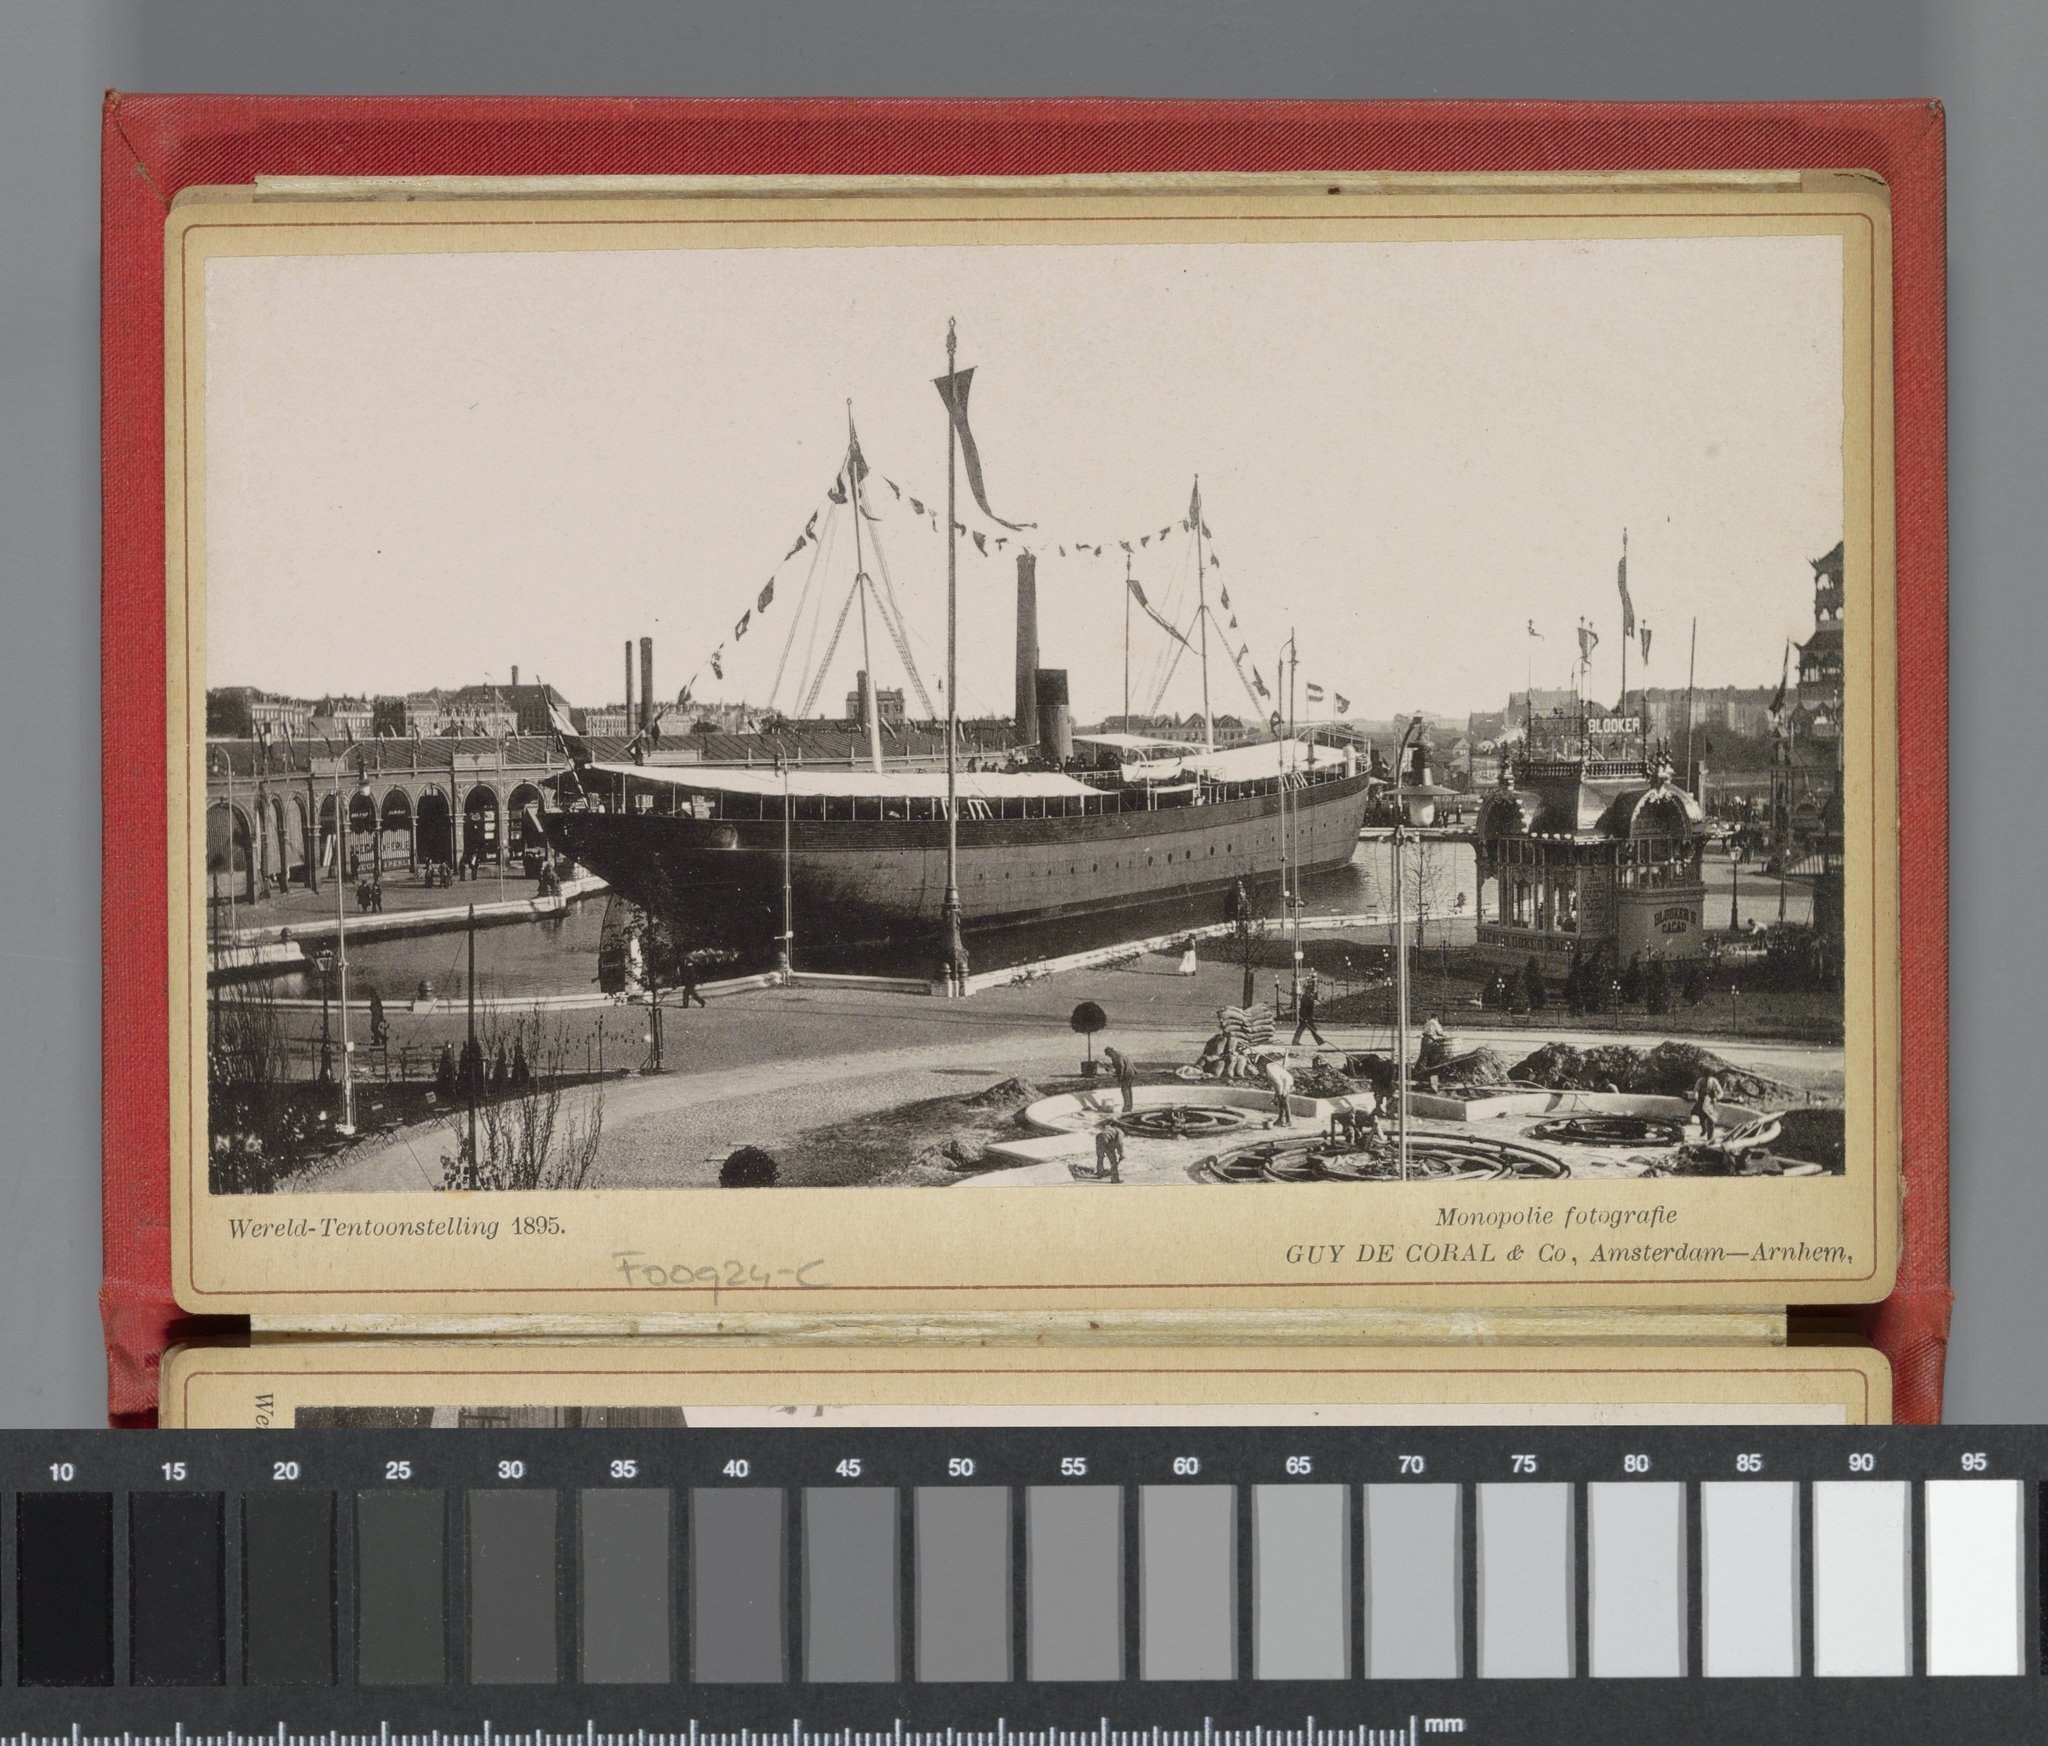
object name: cabinet photograph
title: Wereld-Tentoonstelling 1895.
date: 1895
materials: cardboard, paper, ink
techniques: photograph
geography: amsterdam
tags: prospect of city, town panorama, silhouette of city, temporary exhibition, 'salon', ship-model, amsterdam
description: Onderdeel van Fotoalbum met opnames van de Wereldtentoonstelling voor het Hotel- en Reiswezen op het Museumplein in 1895.